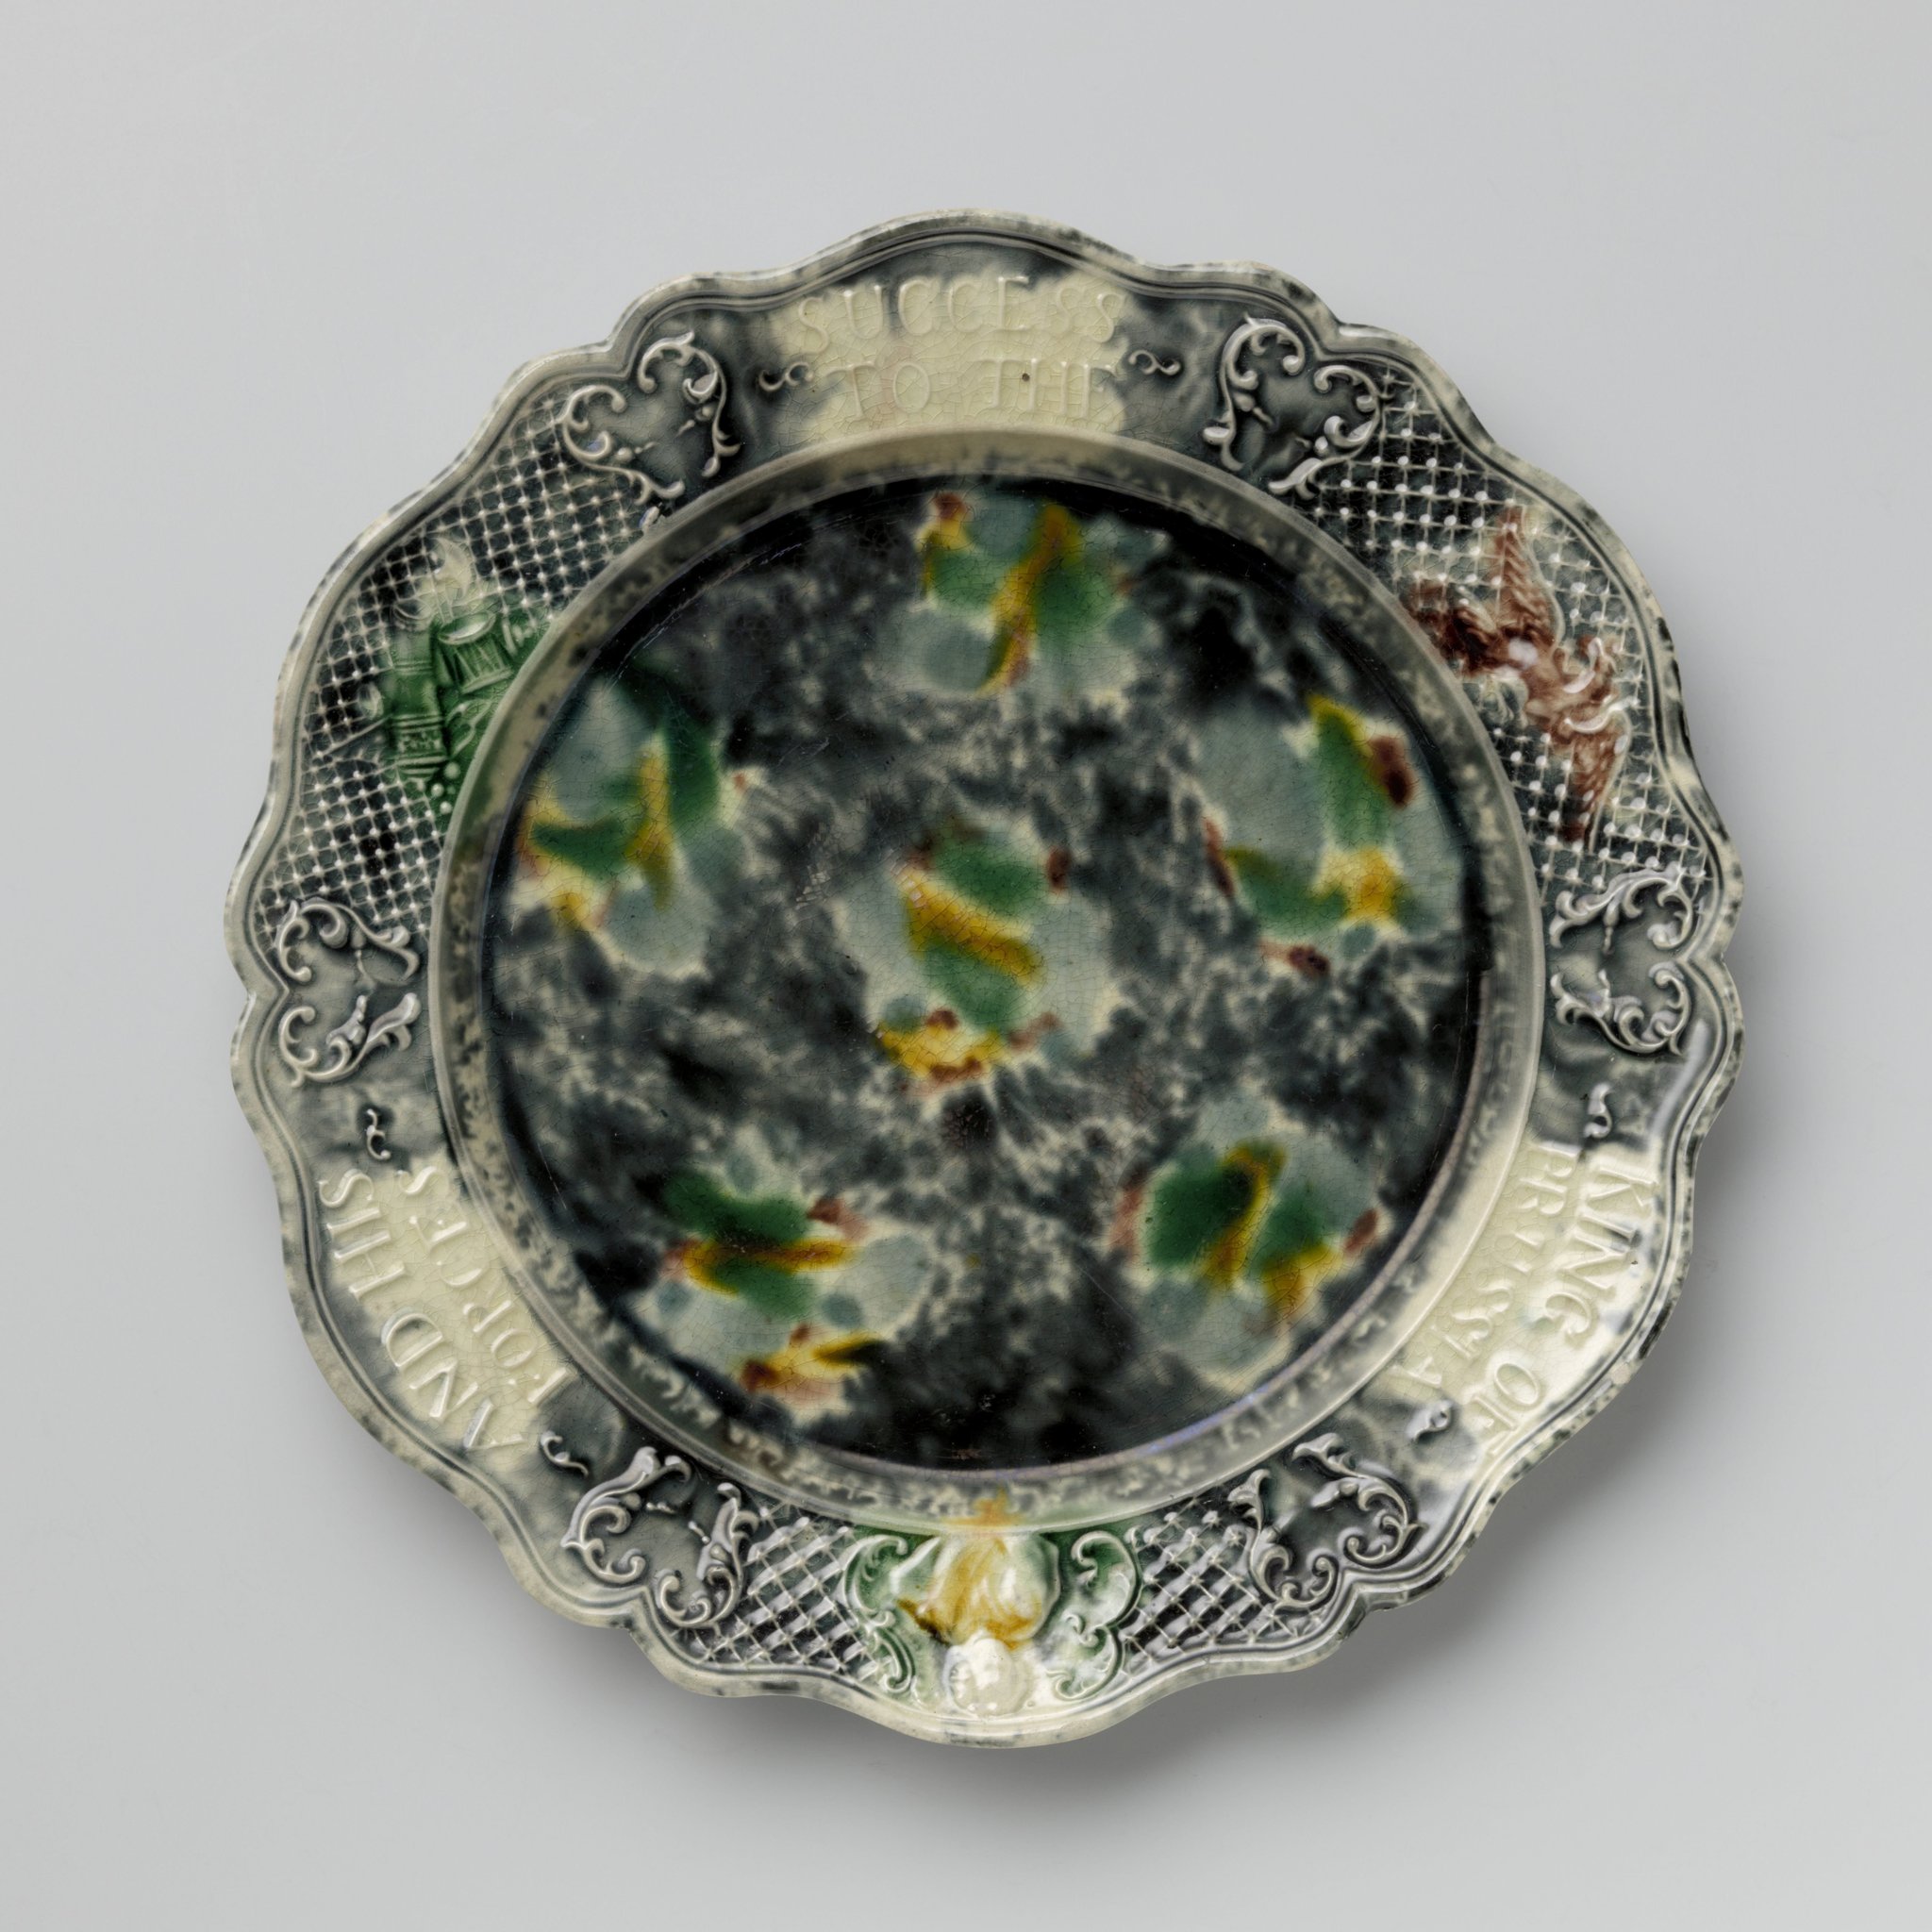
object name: plate dish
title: Rond bord van hardgebakken aardewerk; Staffordshire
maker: Anonymous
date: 1756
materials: earthenware, glaze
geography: england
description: Rond bord van hardgebakken aardewerk, bedekt met blauw-zwarte loodglazuur met vlekken in lichttblauw, groen, geelbruin en mangaan. De rand is in reliëf versierd met velden afwisselend glad en gevuld met traliewerk. Op de tralievelden afwisselend een adelaar, een trofee en het portret van Frederik de Grote. Op de gladde velden de opschriften SUCCES TO THE KING, KING OF PRUSSIA, AND HIS FORCES. Het bord hoort bij vijf borden (BK-1987-40-A t/m BK-1987-40-F).